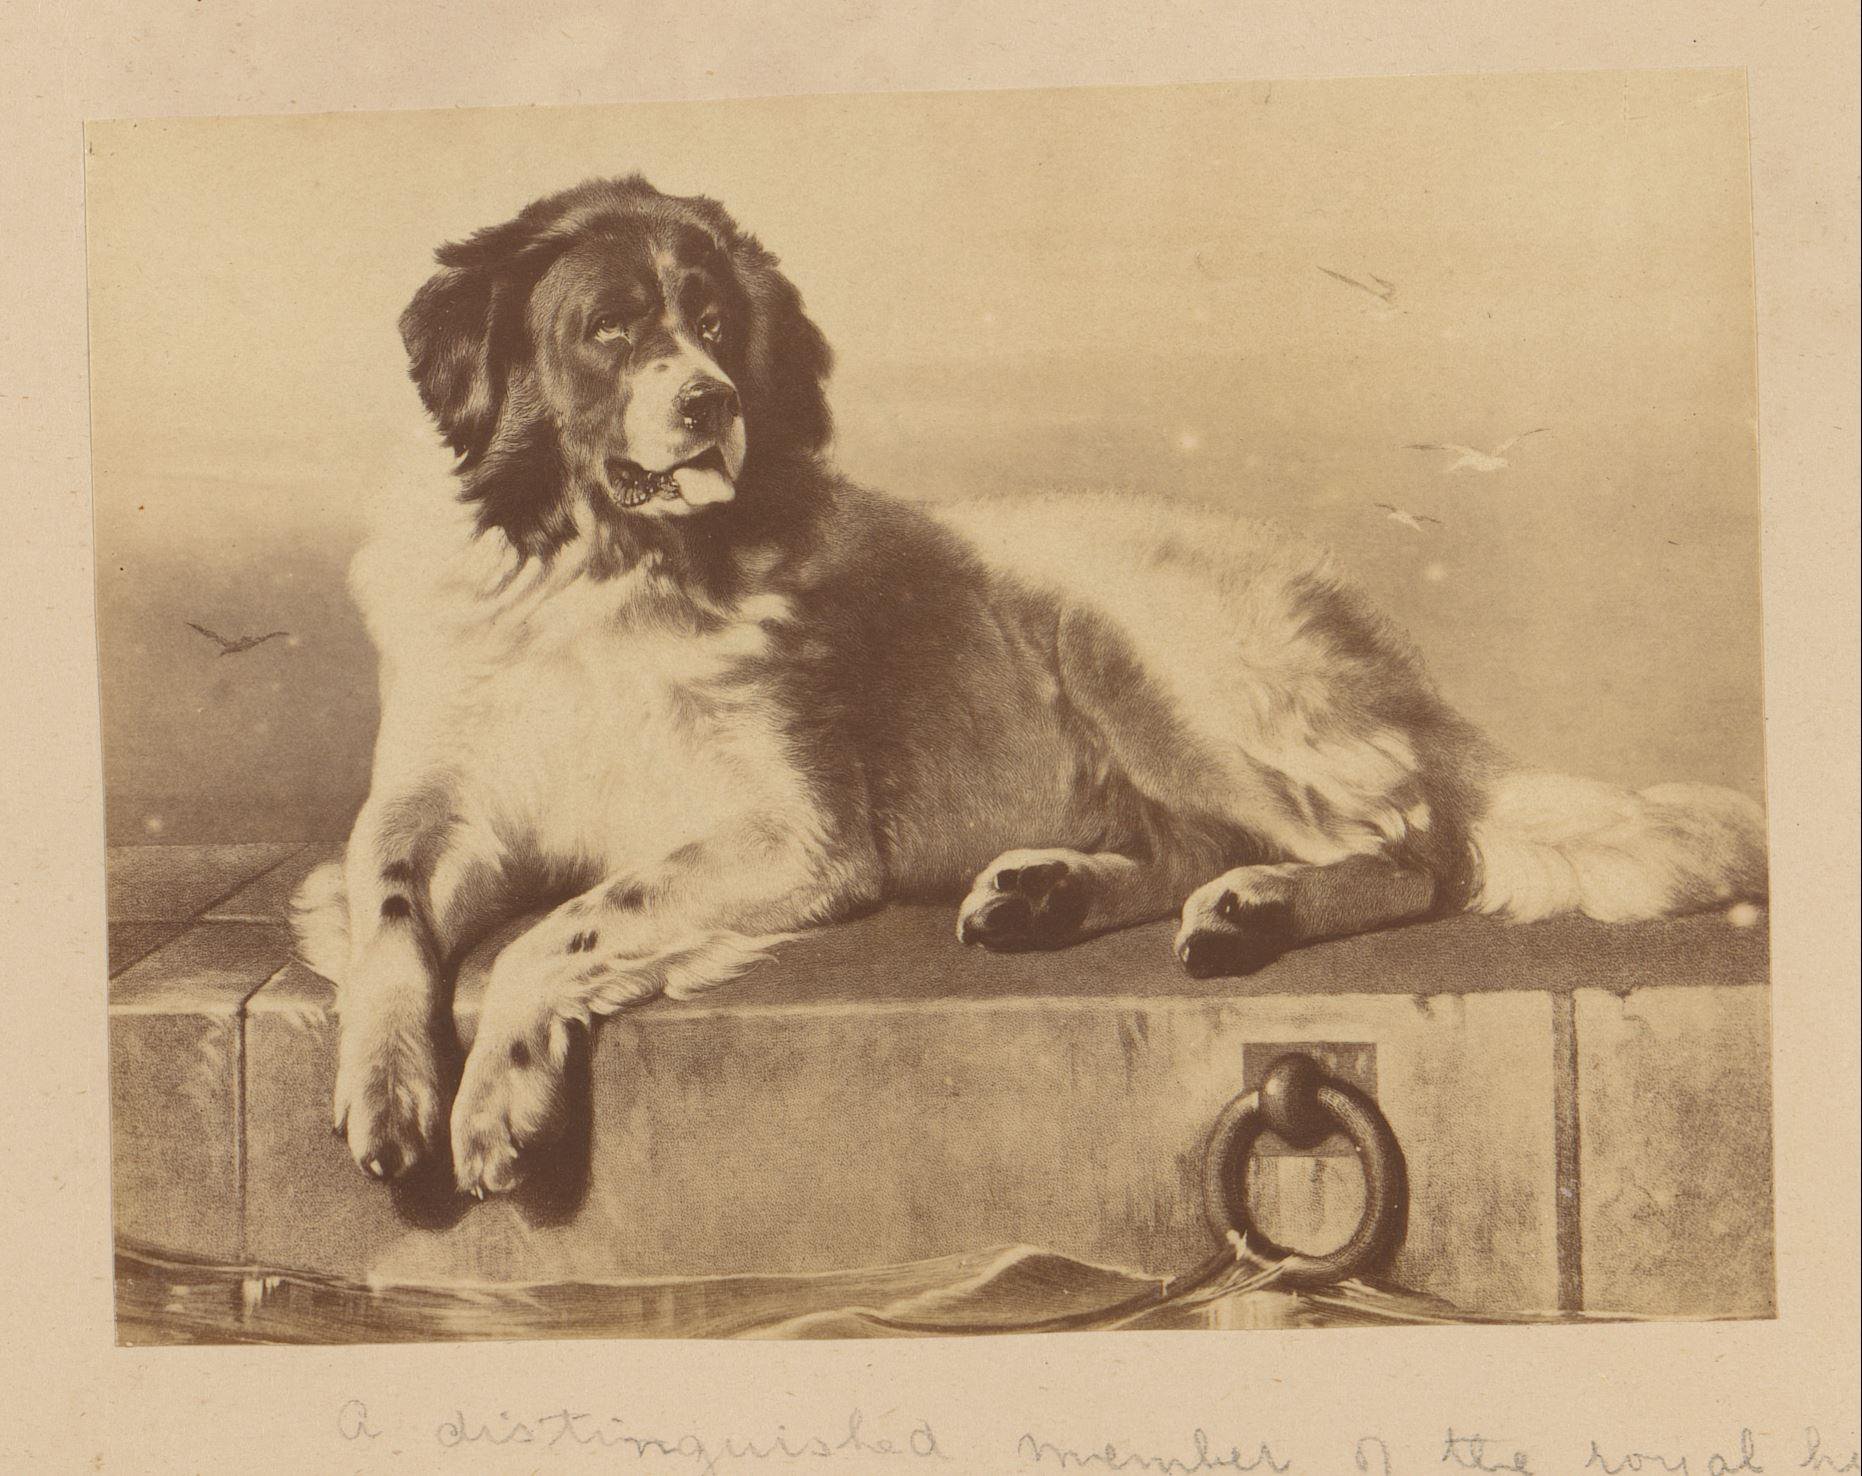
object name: photograph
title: Fotoreproductie van een schilderij van een hond, liggend op een stenen kade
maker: Anonymous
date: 1875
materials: paper, photographic support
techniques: albumen print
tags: dog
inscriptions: annotation: ‘A distinguished member of the royal humane society. Sir E. Landseer.’